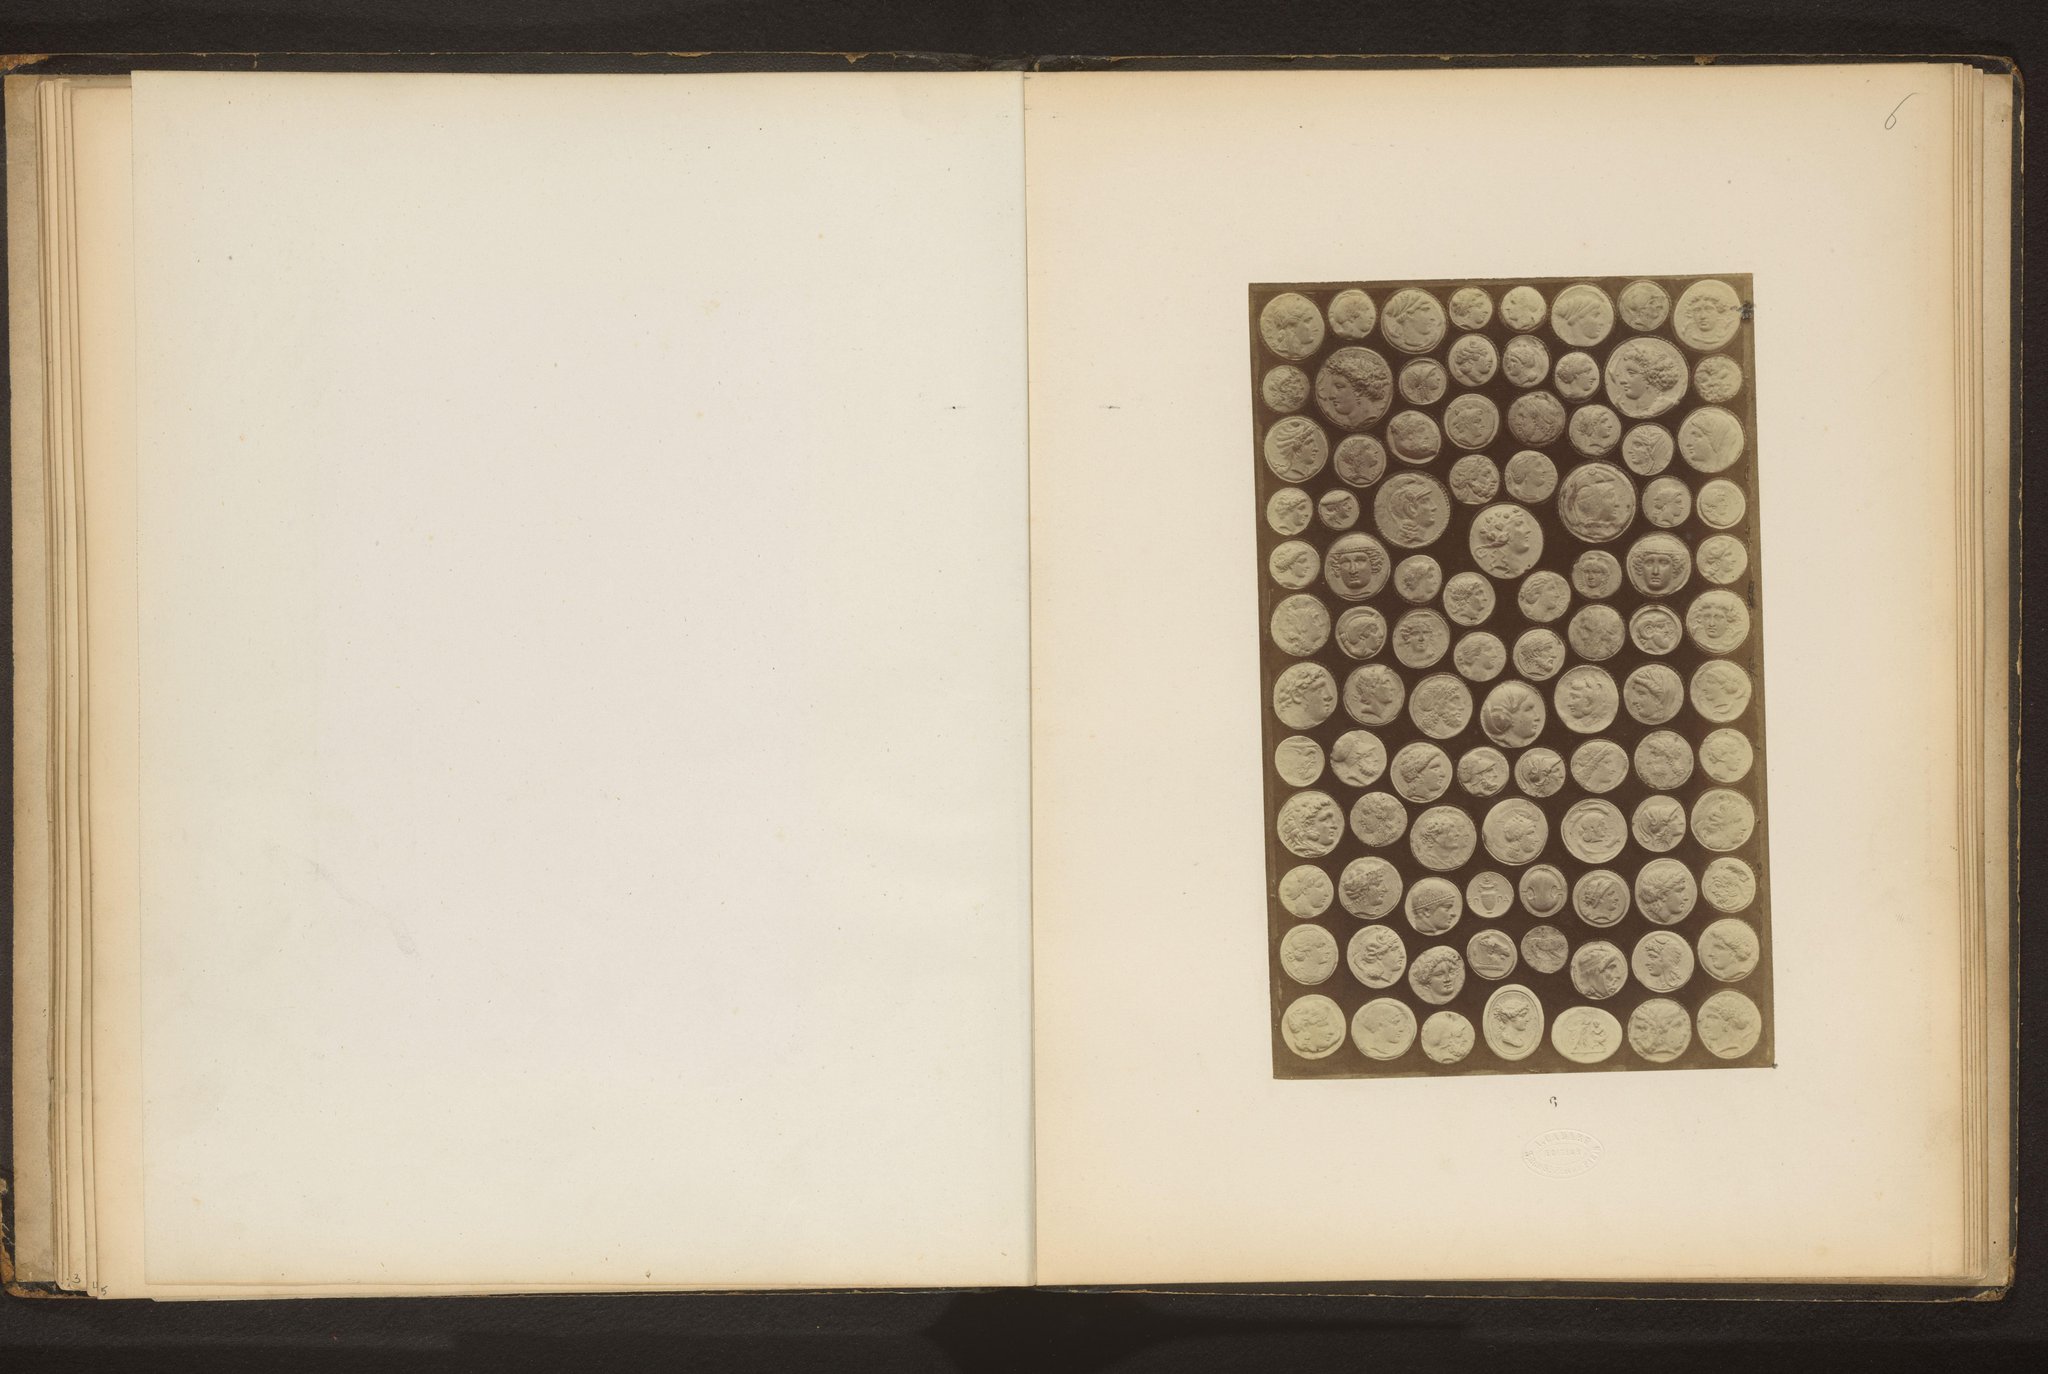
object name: photograph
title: Antieke medailles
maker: Anonymous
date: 1849-1859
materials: photographic support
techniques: albumen print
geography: rome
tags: medal (considered as a piece of sculpture, regardless of its specific function)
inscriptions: number: ‘6’, name: ‘A. Cadart 3. Rue St. Fiacre Paris Editeur’